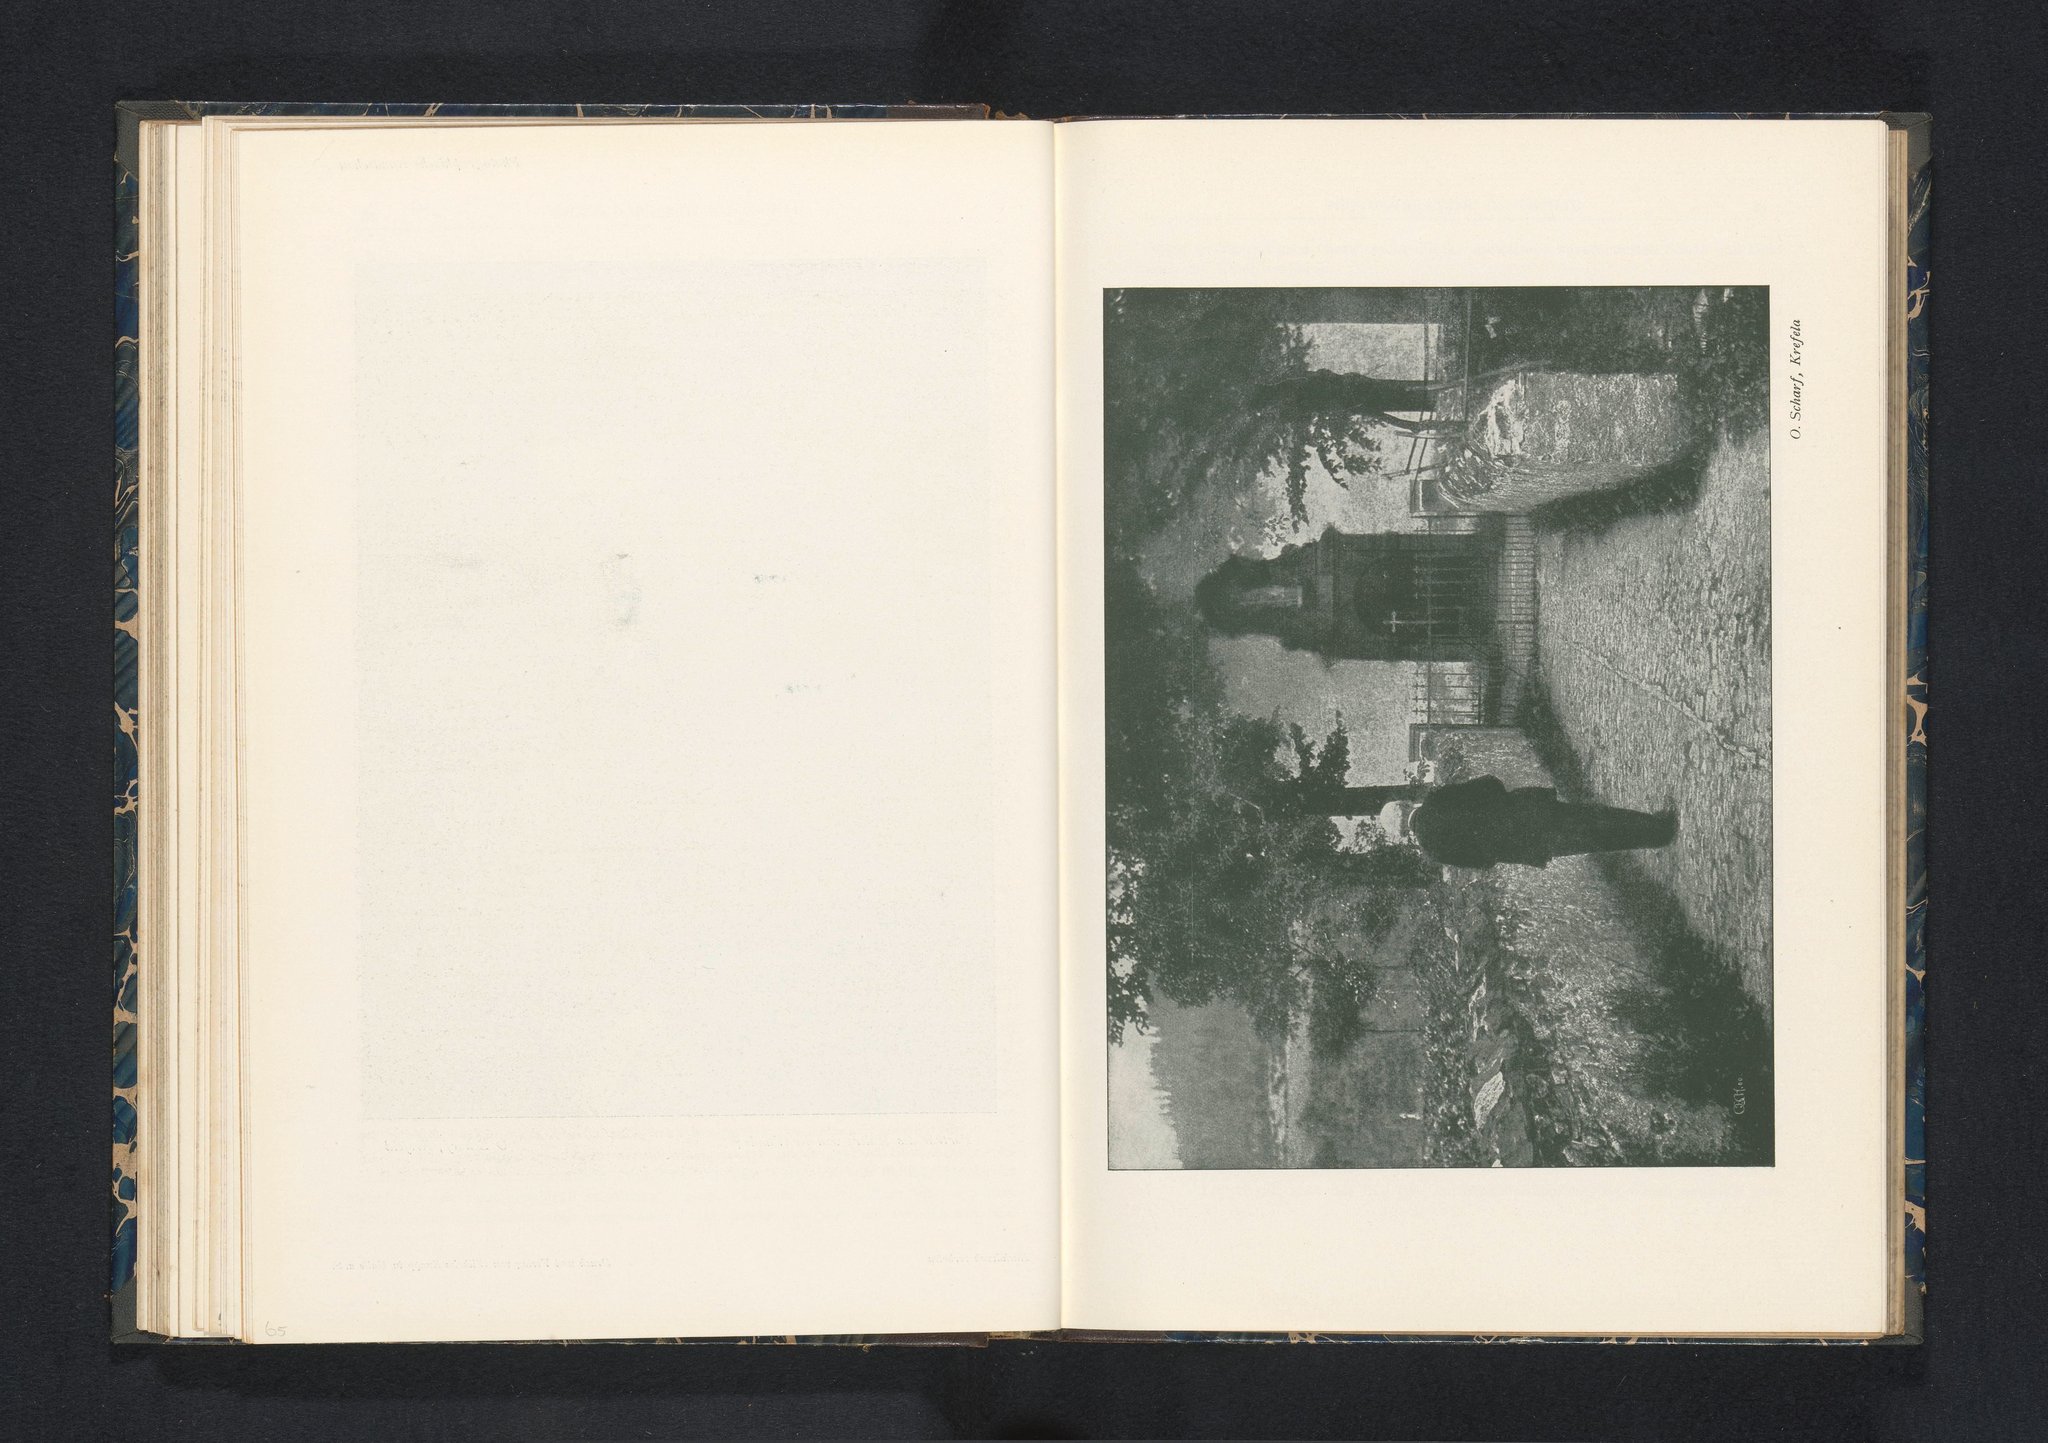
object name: photomechanical print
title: Man staat op een pad, dat leidt naar een begraafplaats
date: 1900-1901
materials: paper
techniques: autotype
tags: adult man, churchyard, cemetery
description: Prent op tweede ongenummerde pagina na pagina 80.